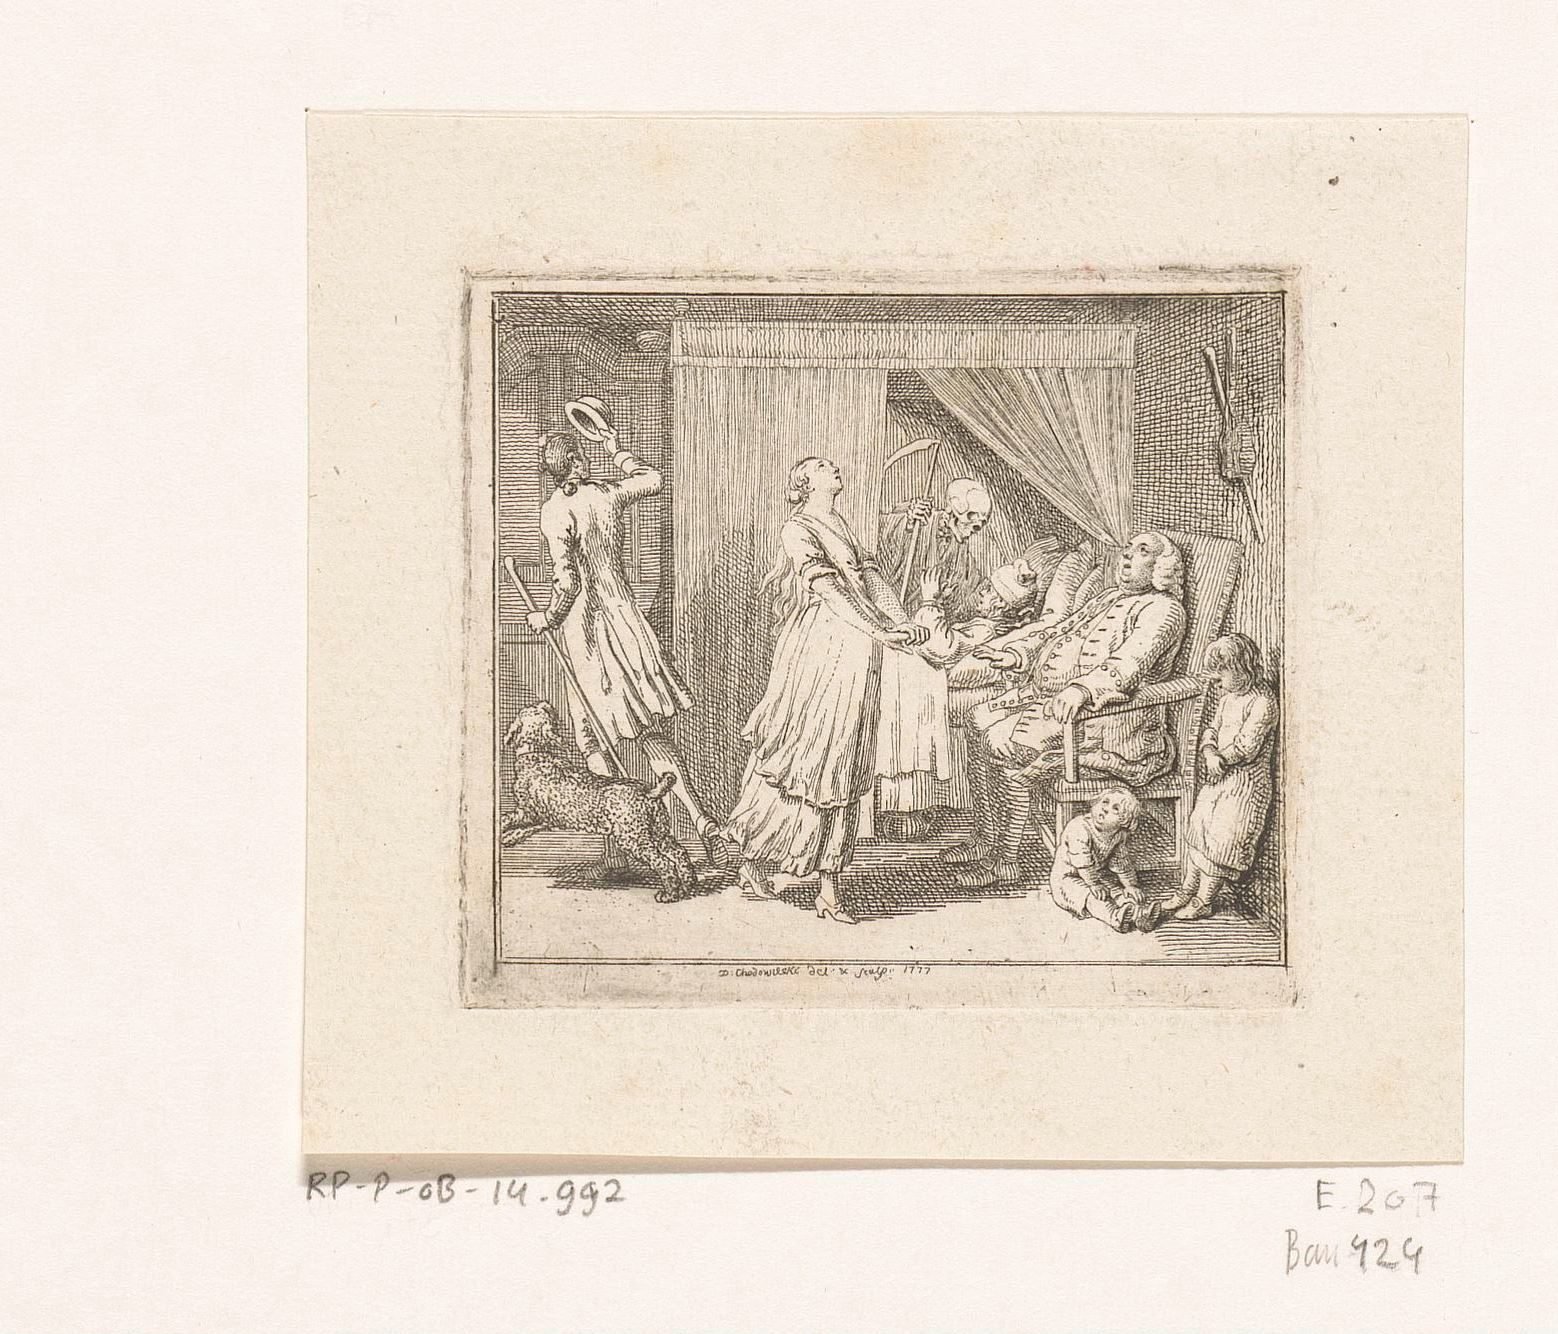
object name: print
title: Zieke man bezocht door de dood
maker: daniel nikolaus chodowiecki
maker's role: draughtsman, print maker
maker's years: 1726-1801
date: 1777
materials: paper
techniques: etching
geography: berlin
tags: draughtsman, matthias claudius, literature, sick-bed, death as skeleton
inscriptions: collector's mark: Lugt 2228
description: Een latere staat van deze prent is ook gebruikt in 'Asmus omnia sua secum portans, oder Sämtliche Werke des Wandsbecker Bothen', een verzamelwerk in de vorm van een tijdschrift, uitgegeven tussen 1775-1812. Deze prent gebruikt in deel 3.